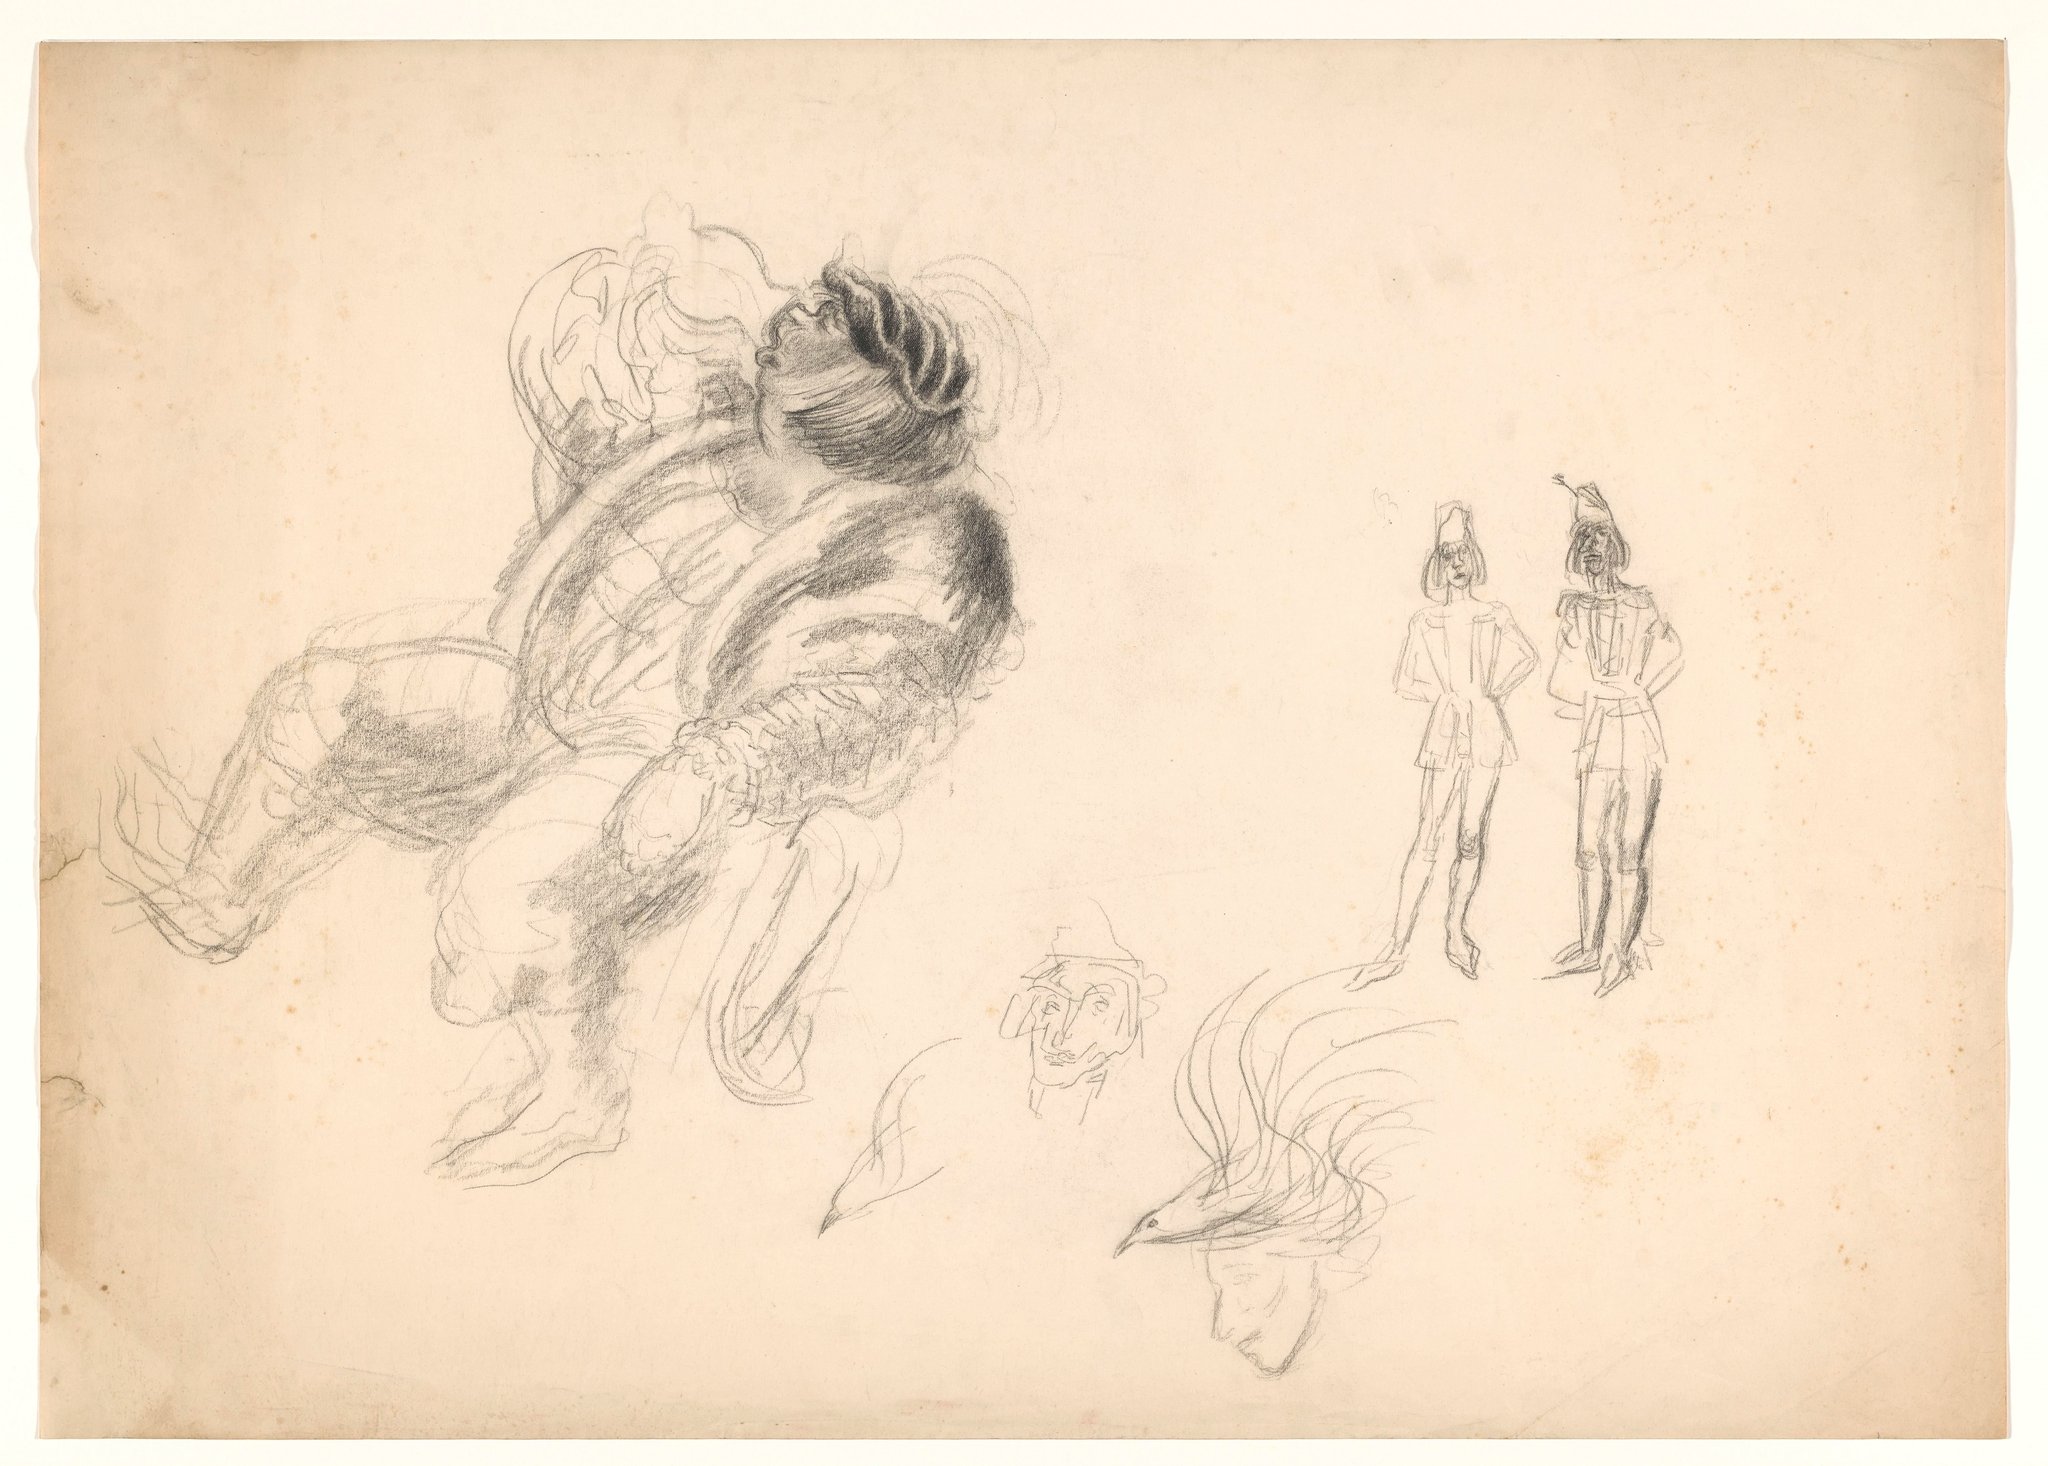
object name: drawing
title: Drinkende reus, twee figuren, een gezicht met een vogel in het haar en het gezicht van een man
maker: henk henriët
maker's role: draughtsman, print maker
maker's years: 1903-1945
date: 1936-1940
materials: chalk, paper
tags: birds, giants, colossi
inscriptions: collector's mark: Lugt 2228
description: Deze tekening is mogelijk een ontwerp voor een illustratie bij het boek 'Gargantua en Pantagruel' van François Rabelais.